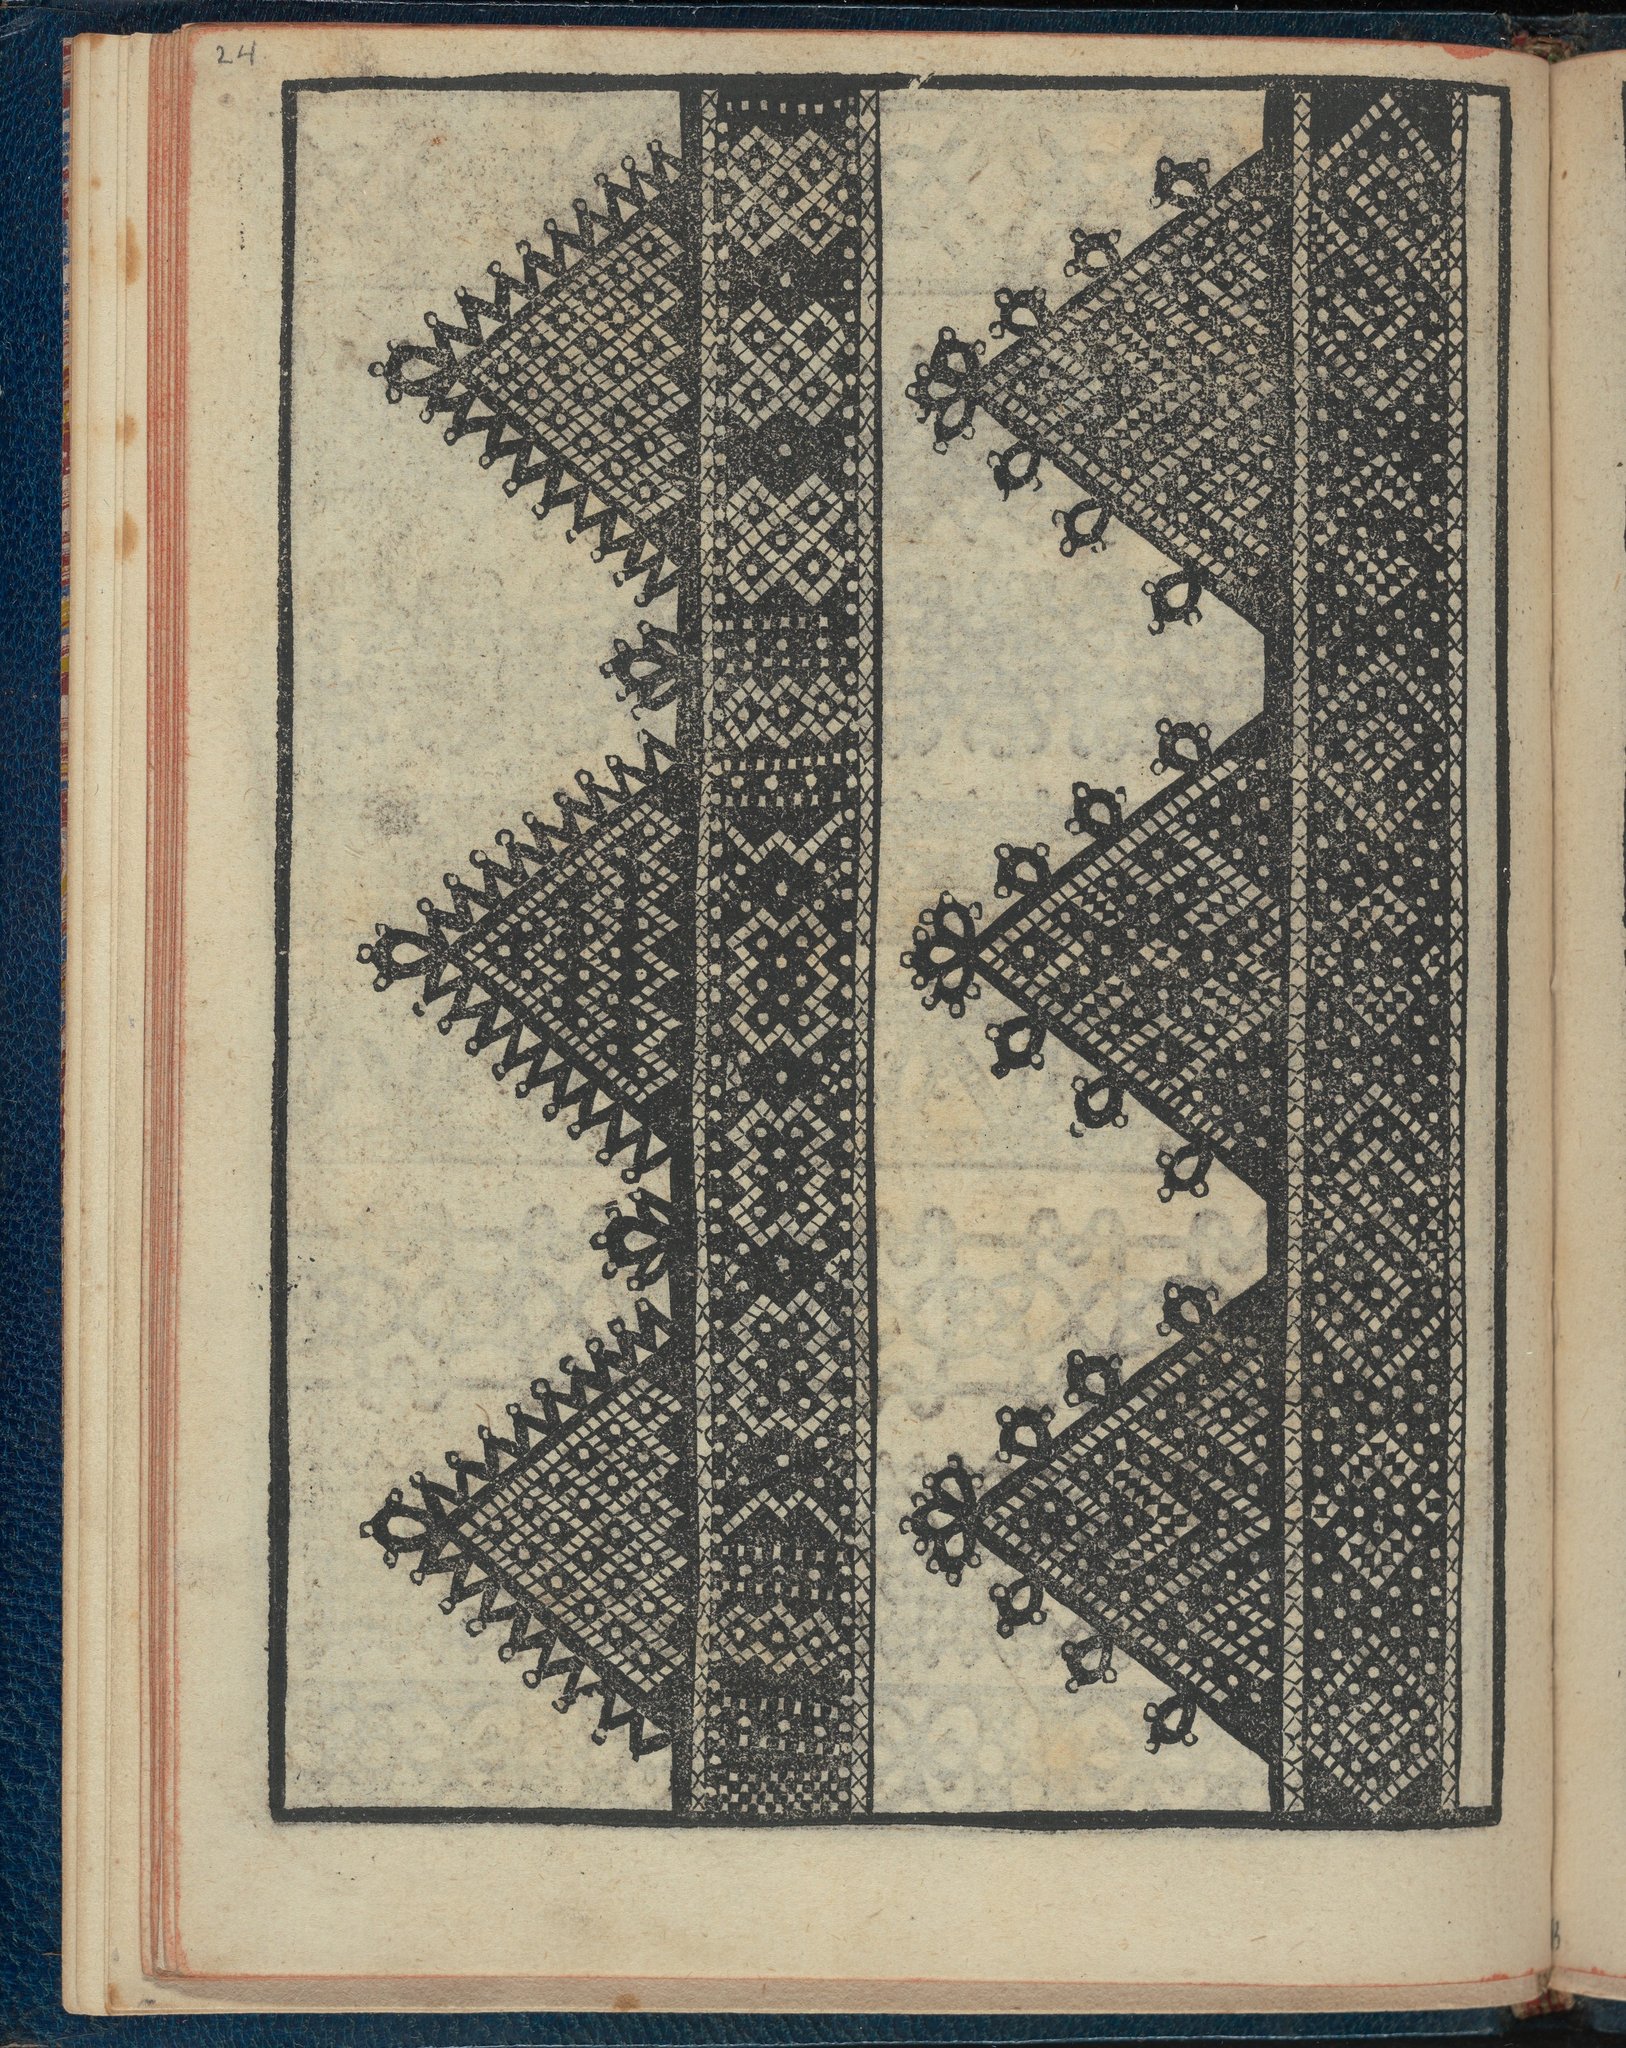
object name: book print ornament architecture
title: Le Pompe: Opera Nova, page 12 (verso)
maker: giovanni battista & marchio sessa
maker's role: publisher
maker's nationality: italian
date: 1557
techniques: woodcut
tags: ornament